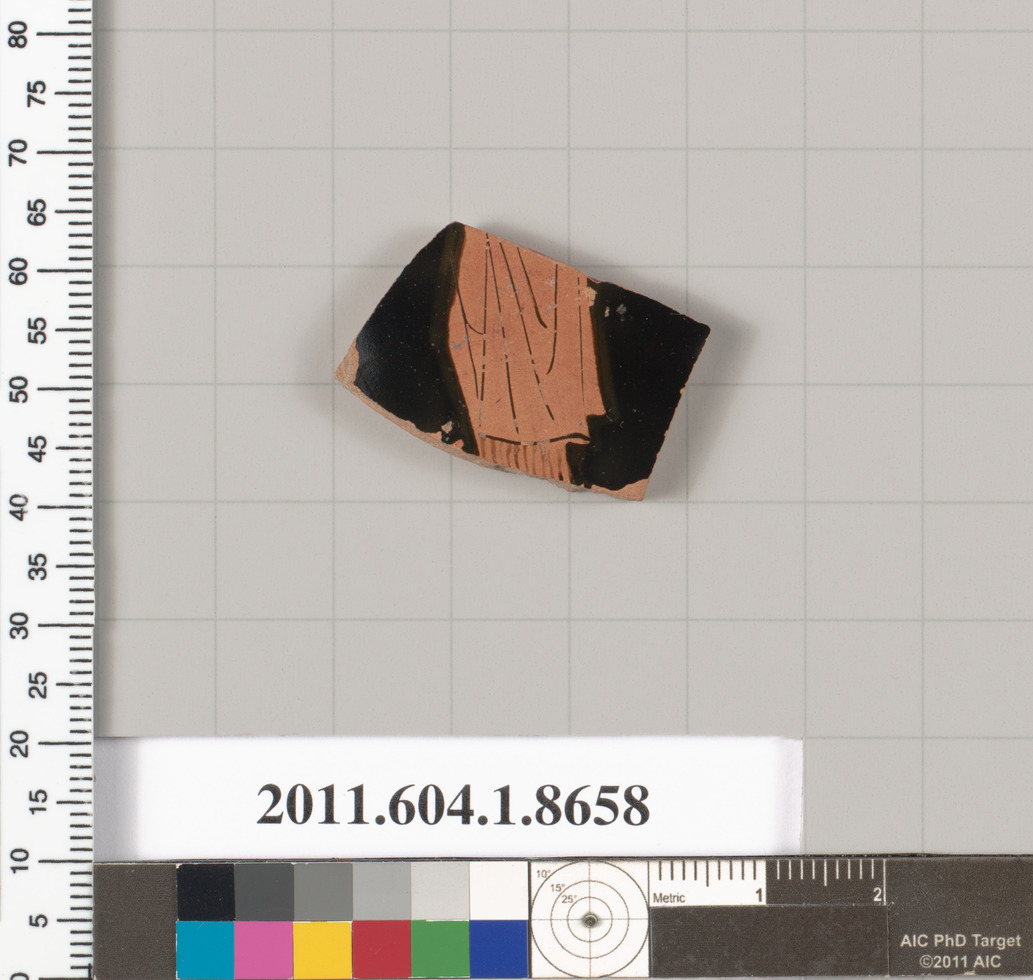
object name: kylix fragment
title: Terracotta rim fragment of a stemless? kylix (drinking cup)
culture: greek, attic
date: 460-450 BCE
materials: terracotta